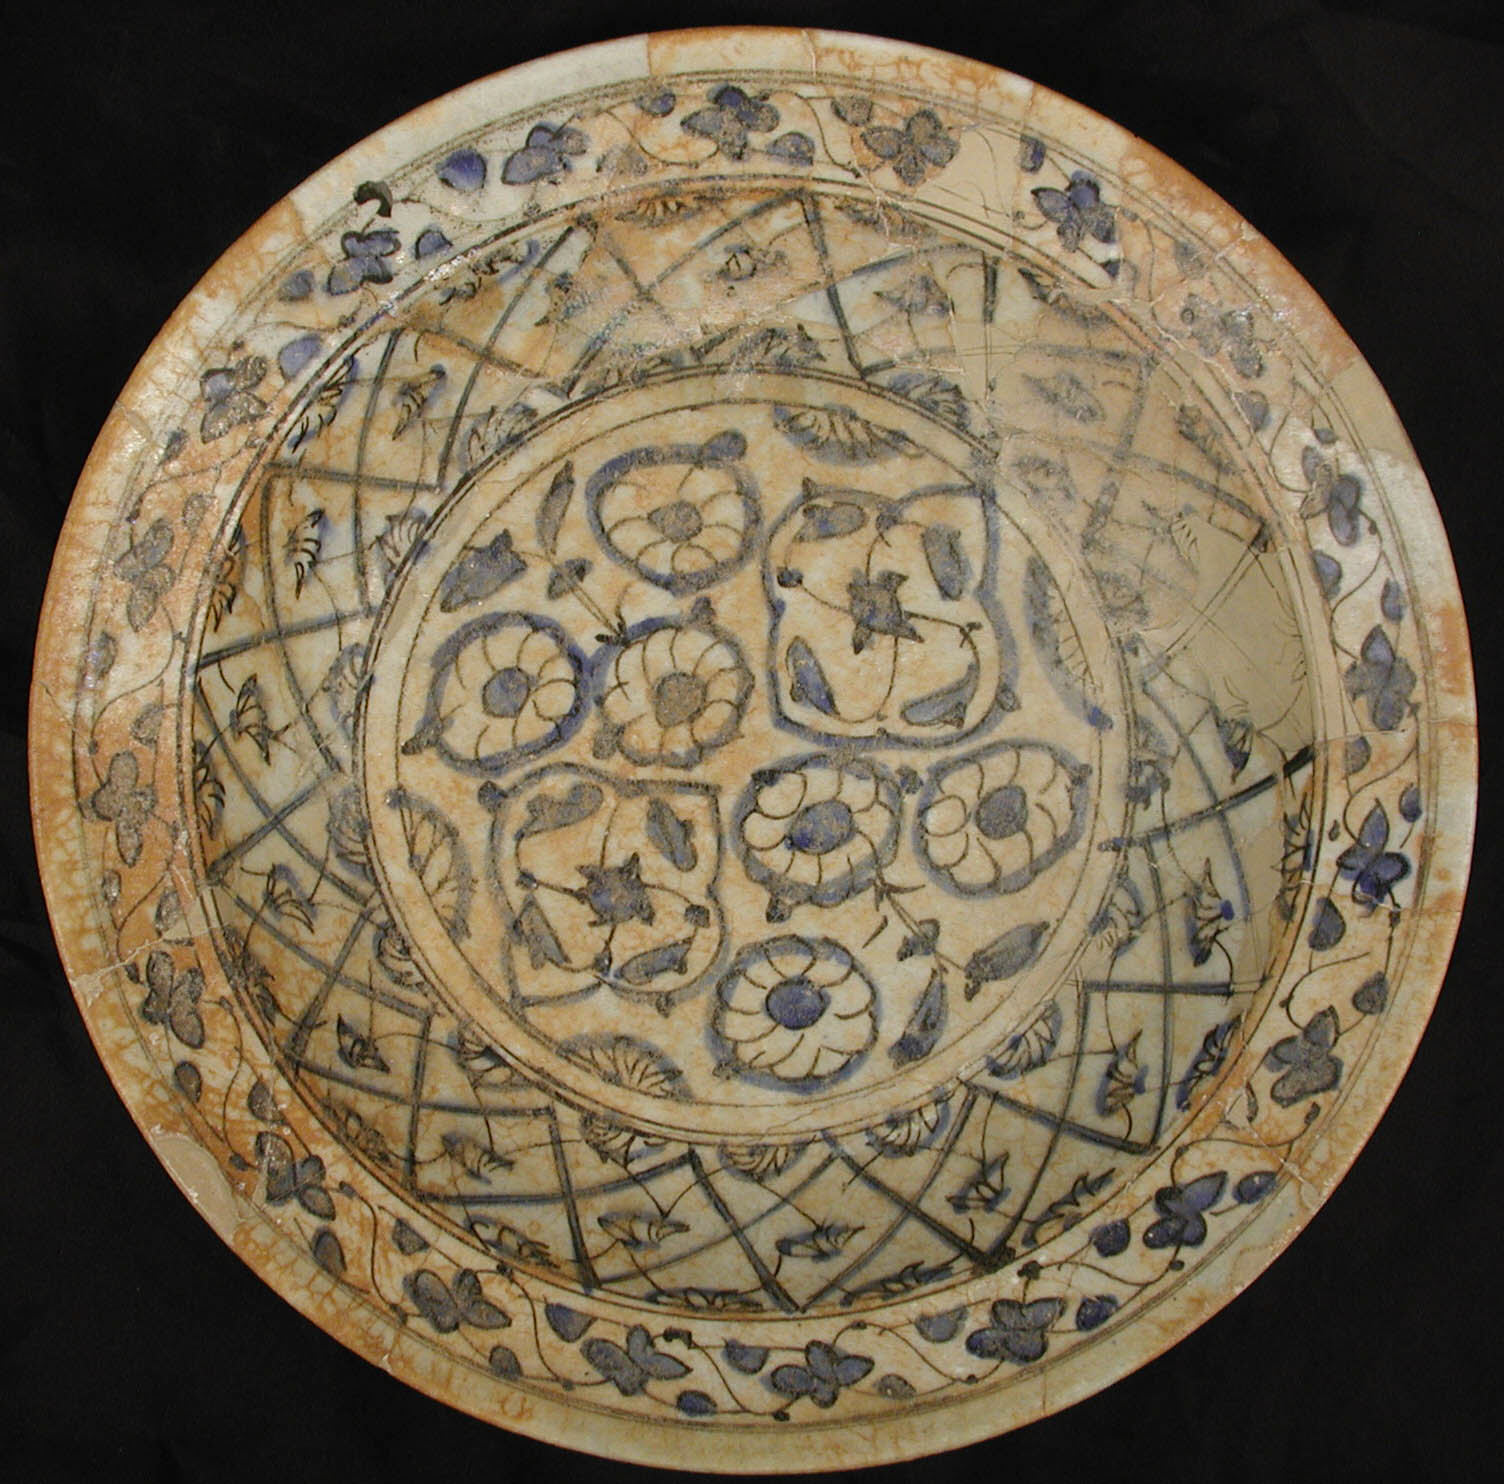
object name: dish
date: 1401-1500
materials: earthenware, glaze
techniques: polychrome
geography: iran